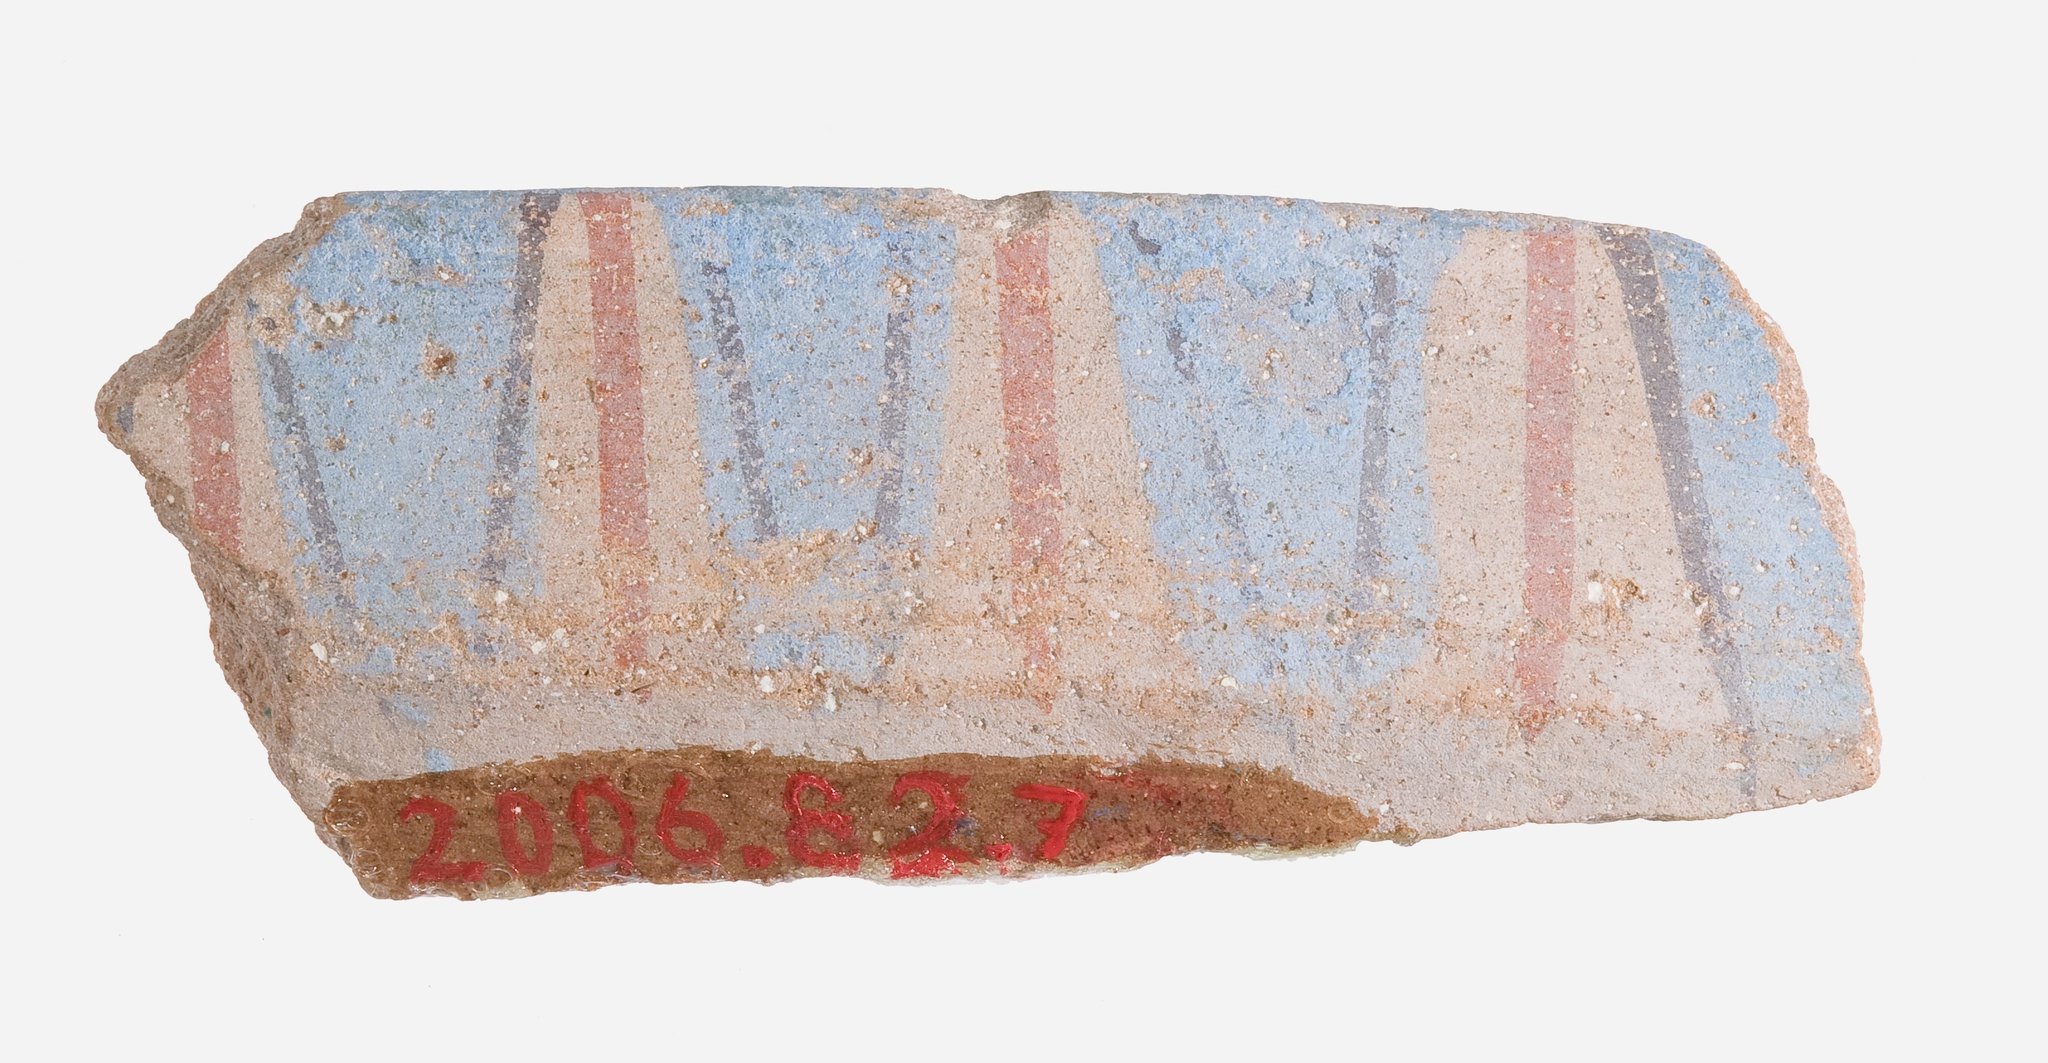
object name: vessel fragment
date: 1390-1352 BCE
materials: paint, pottery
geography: egypt